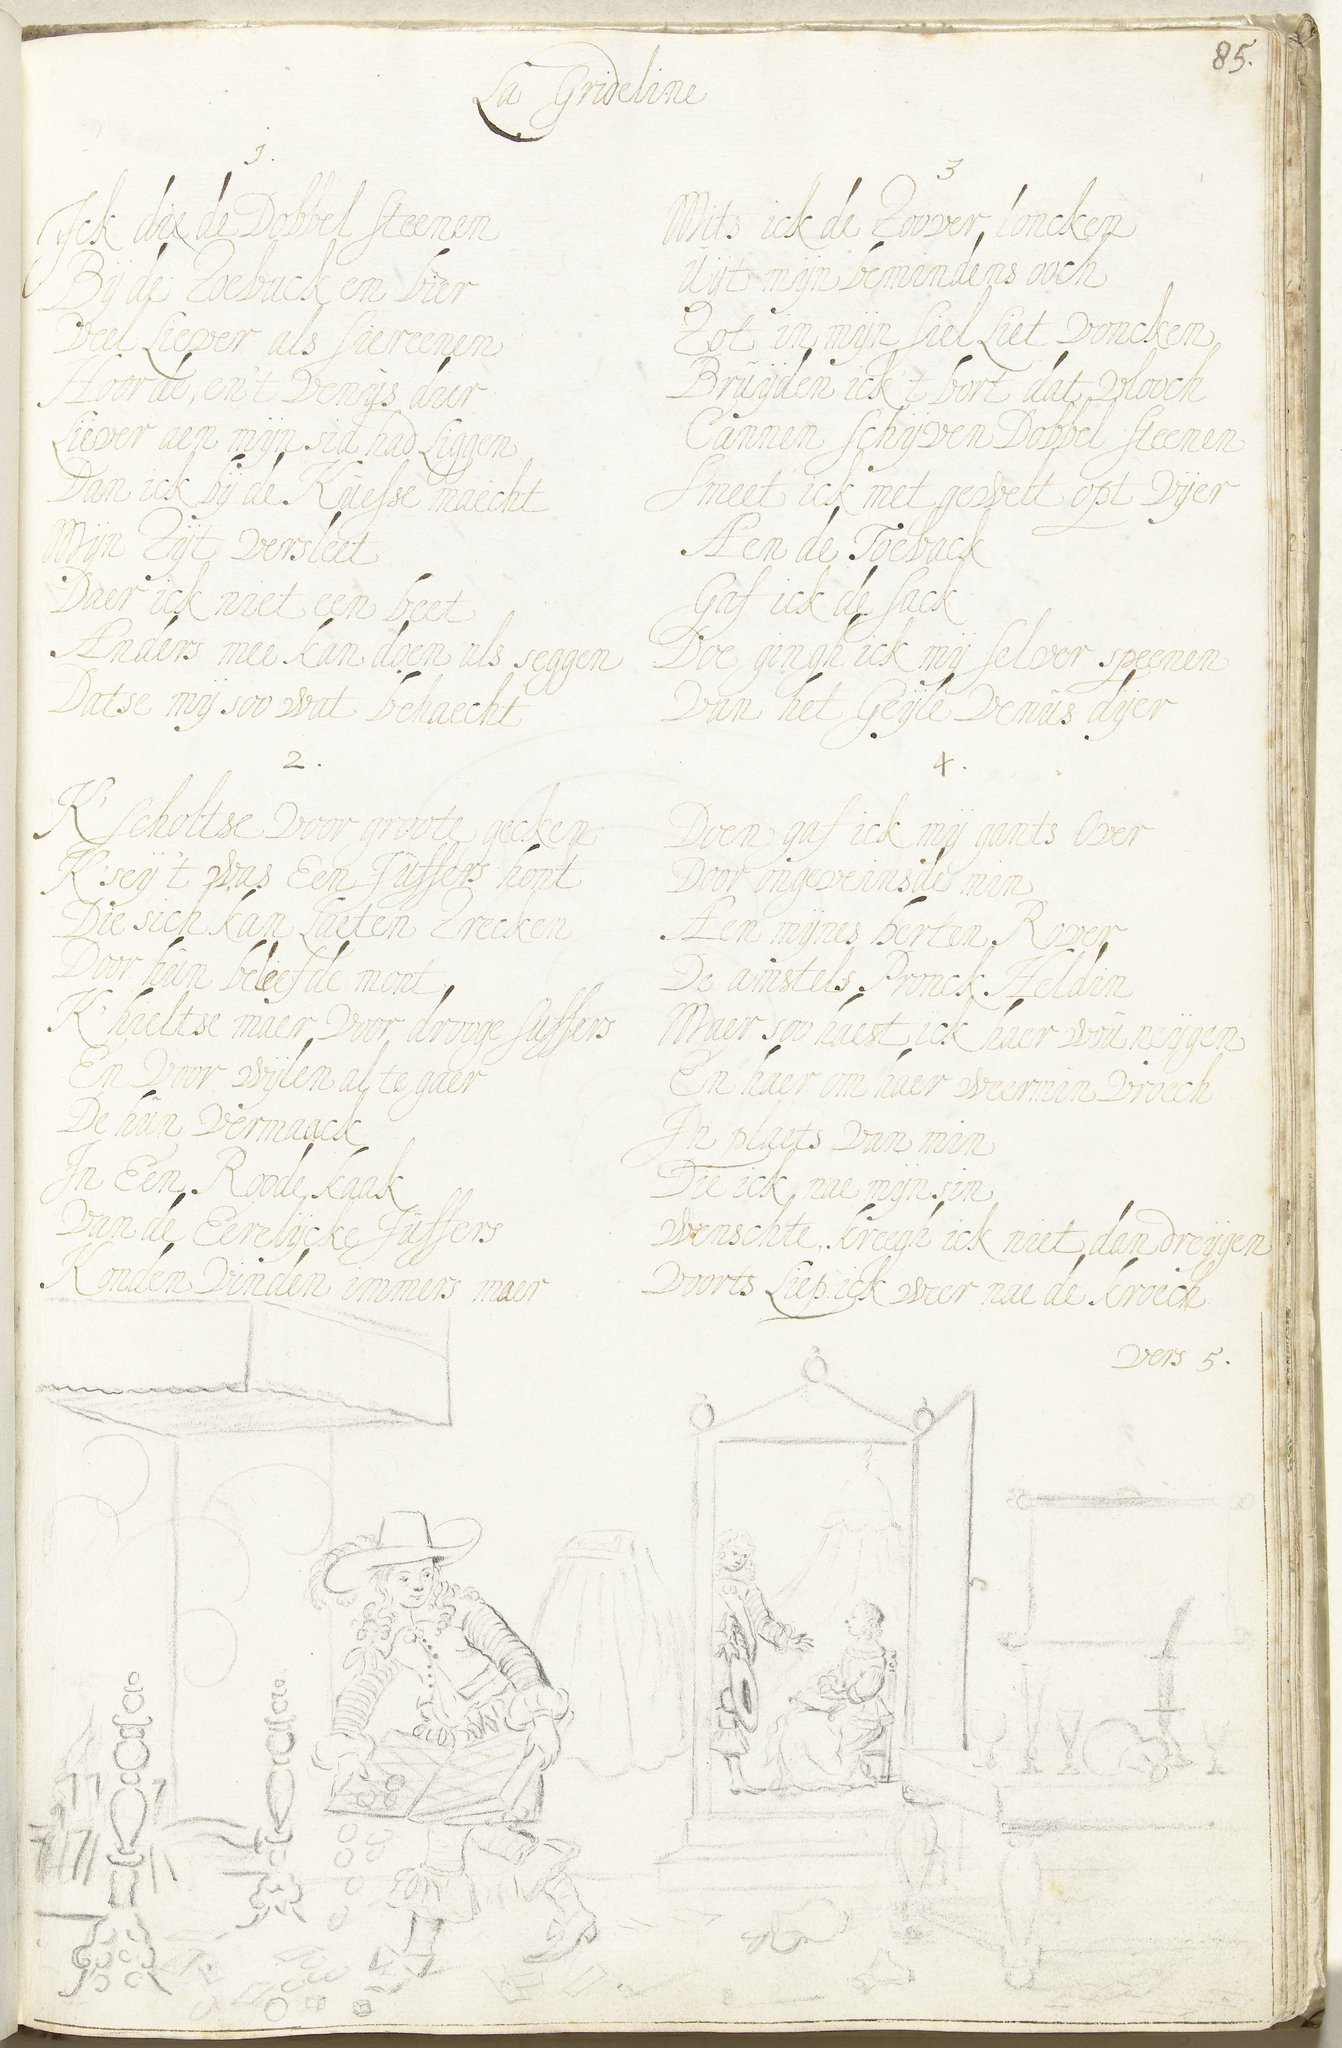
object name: drawing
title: Herberginterieur met een trictracspeler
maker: gesina ter borch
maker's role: draughtsman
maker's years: 1633-1690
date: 1658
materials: ink, paper, pencil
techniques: calligraphy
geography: zwolle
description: Herberginterieur met een trictracspeler onder drinklied op de melodie van La Grideline.